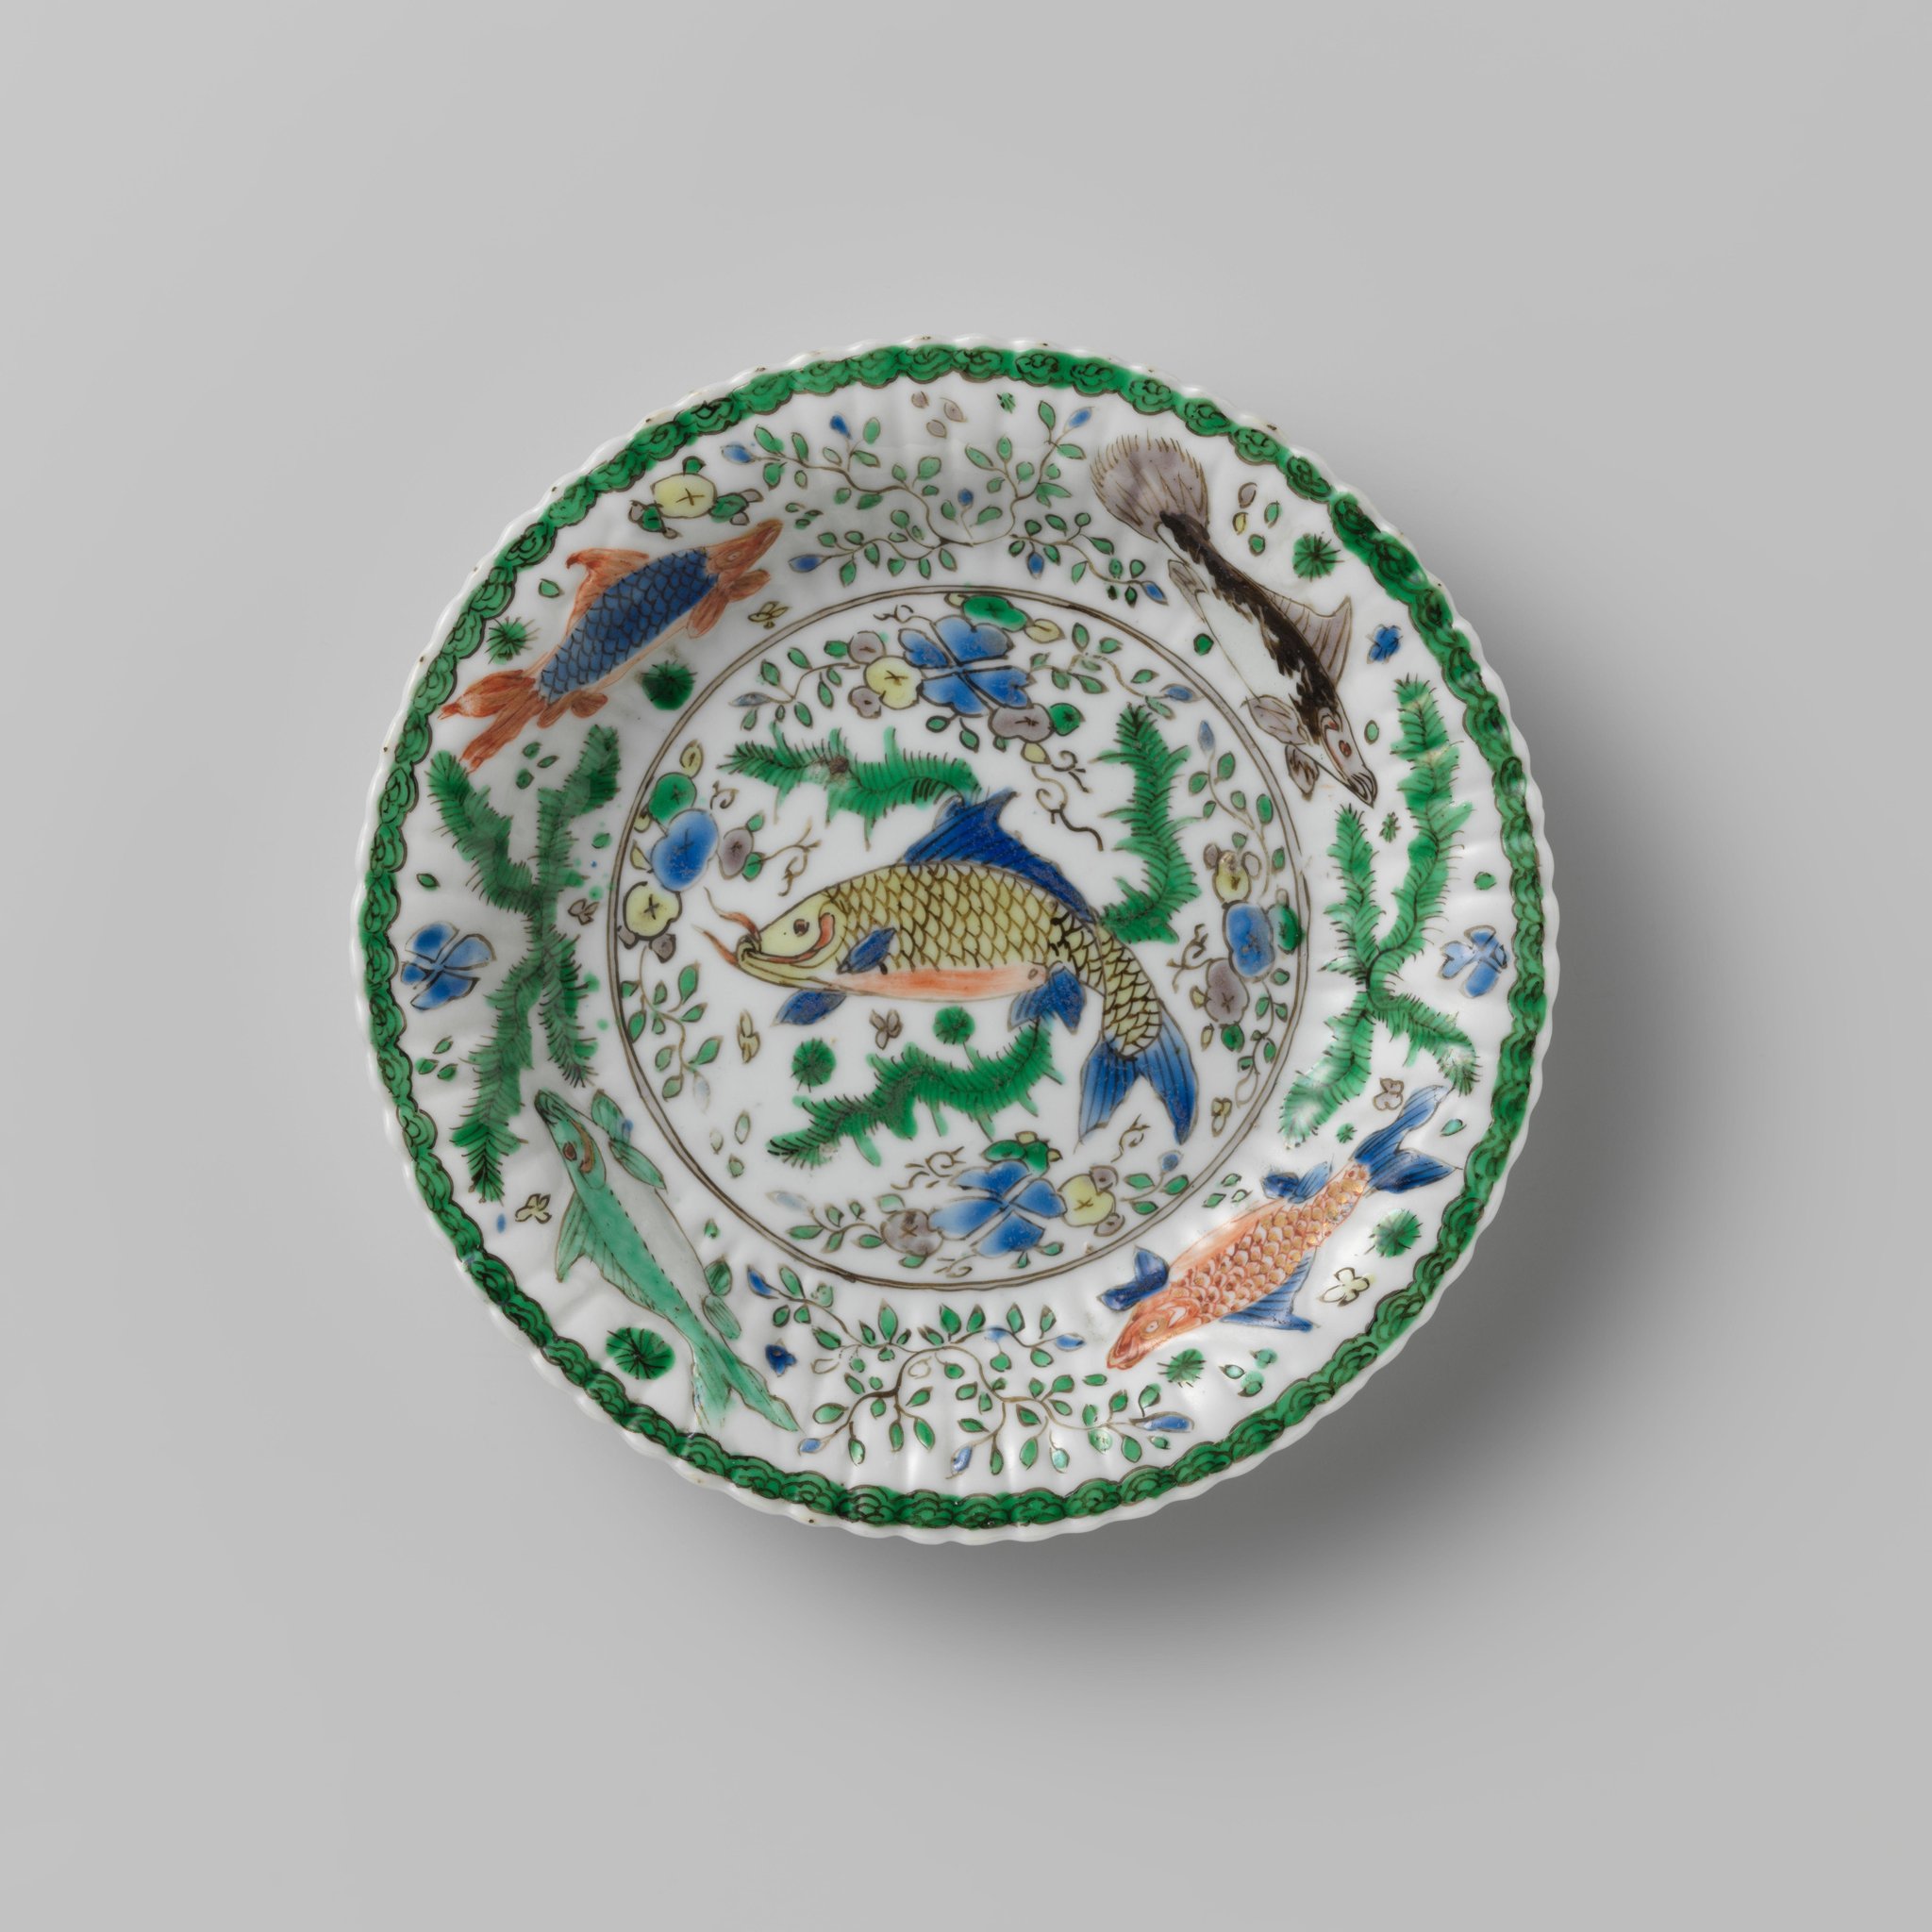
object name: platter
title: Saucer with fish between water plants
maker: Anonymous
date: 1700-1724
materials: cobalt, glaze, gold, paint, porcelain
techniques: firing, turning, vitrification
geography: china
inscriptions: mark: ‘玉’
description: Schotel van porselein met geribde wand en gelobde rand, beschilderd in onderglazuur blauw en op het glazuur blauw, rood, groen, geel, aubergine, zwart en goud. Het plat van de schotel met een vis tussen waterplanten en vier kleinere vissen tussen waterplanten op de wand en rand, de rand met een band ruyi-motief; op de buitenzijde vier vissen in ijzerrood. Gemerkt op de onderzijde met 'Yù', jade, in een dubbele cirkel. Famille verte.